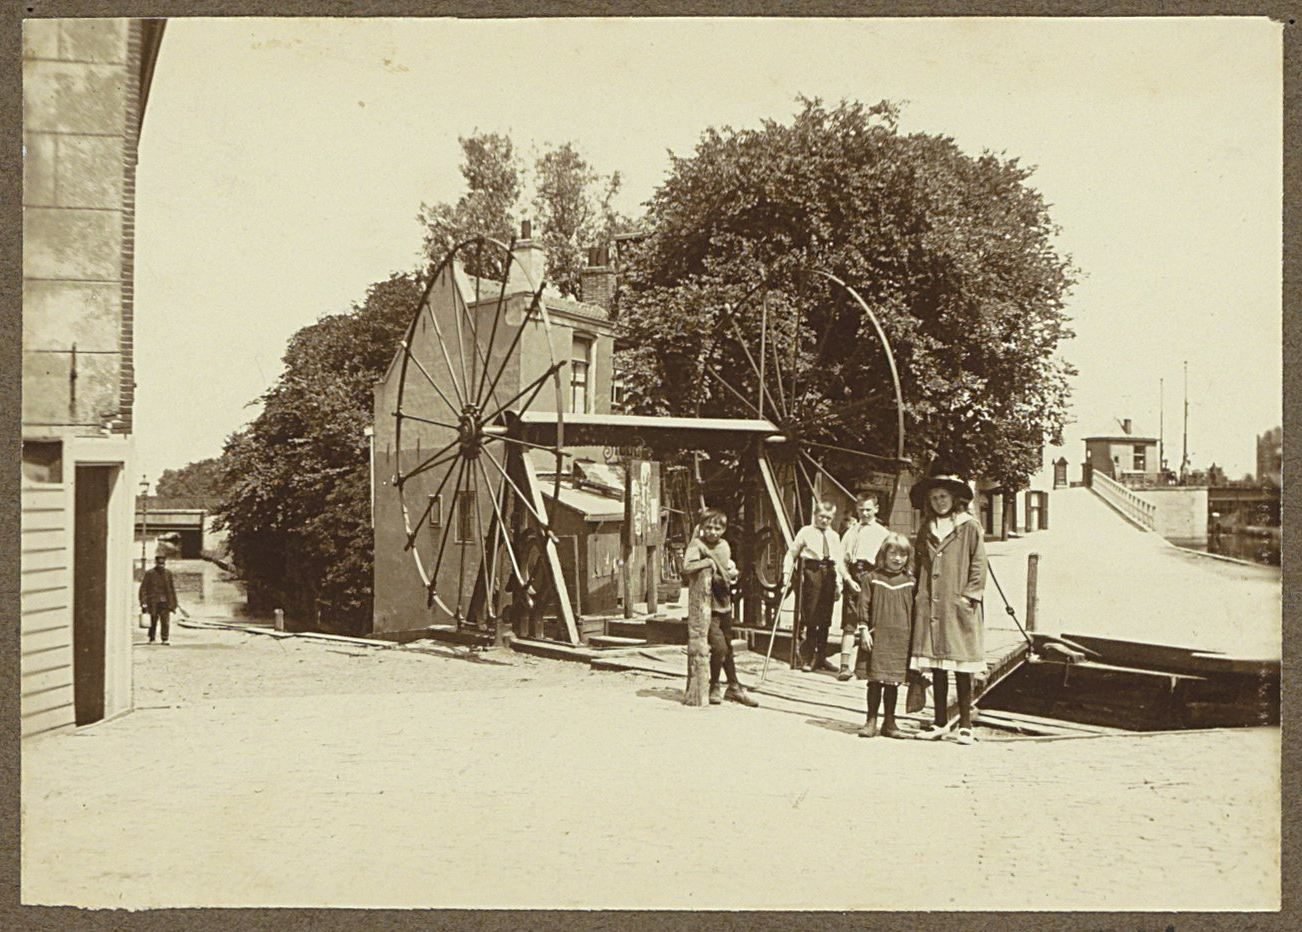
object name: photograph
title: Kinderen bij de overhaal aan de Baarsjesweg te Amsterdam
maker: Anonymous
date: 1910-1930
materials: paper, photographic support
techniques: daylight paper print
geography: amsterdam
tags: sluice, weir, amsterdam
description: Onderdeel van Album met foto's van Amsterdam en omgeving.